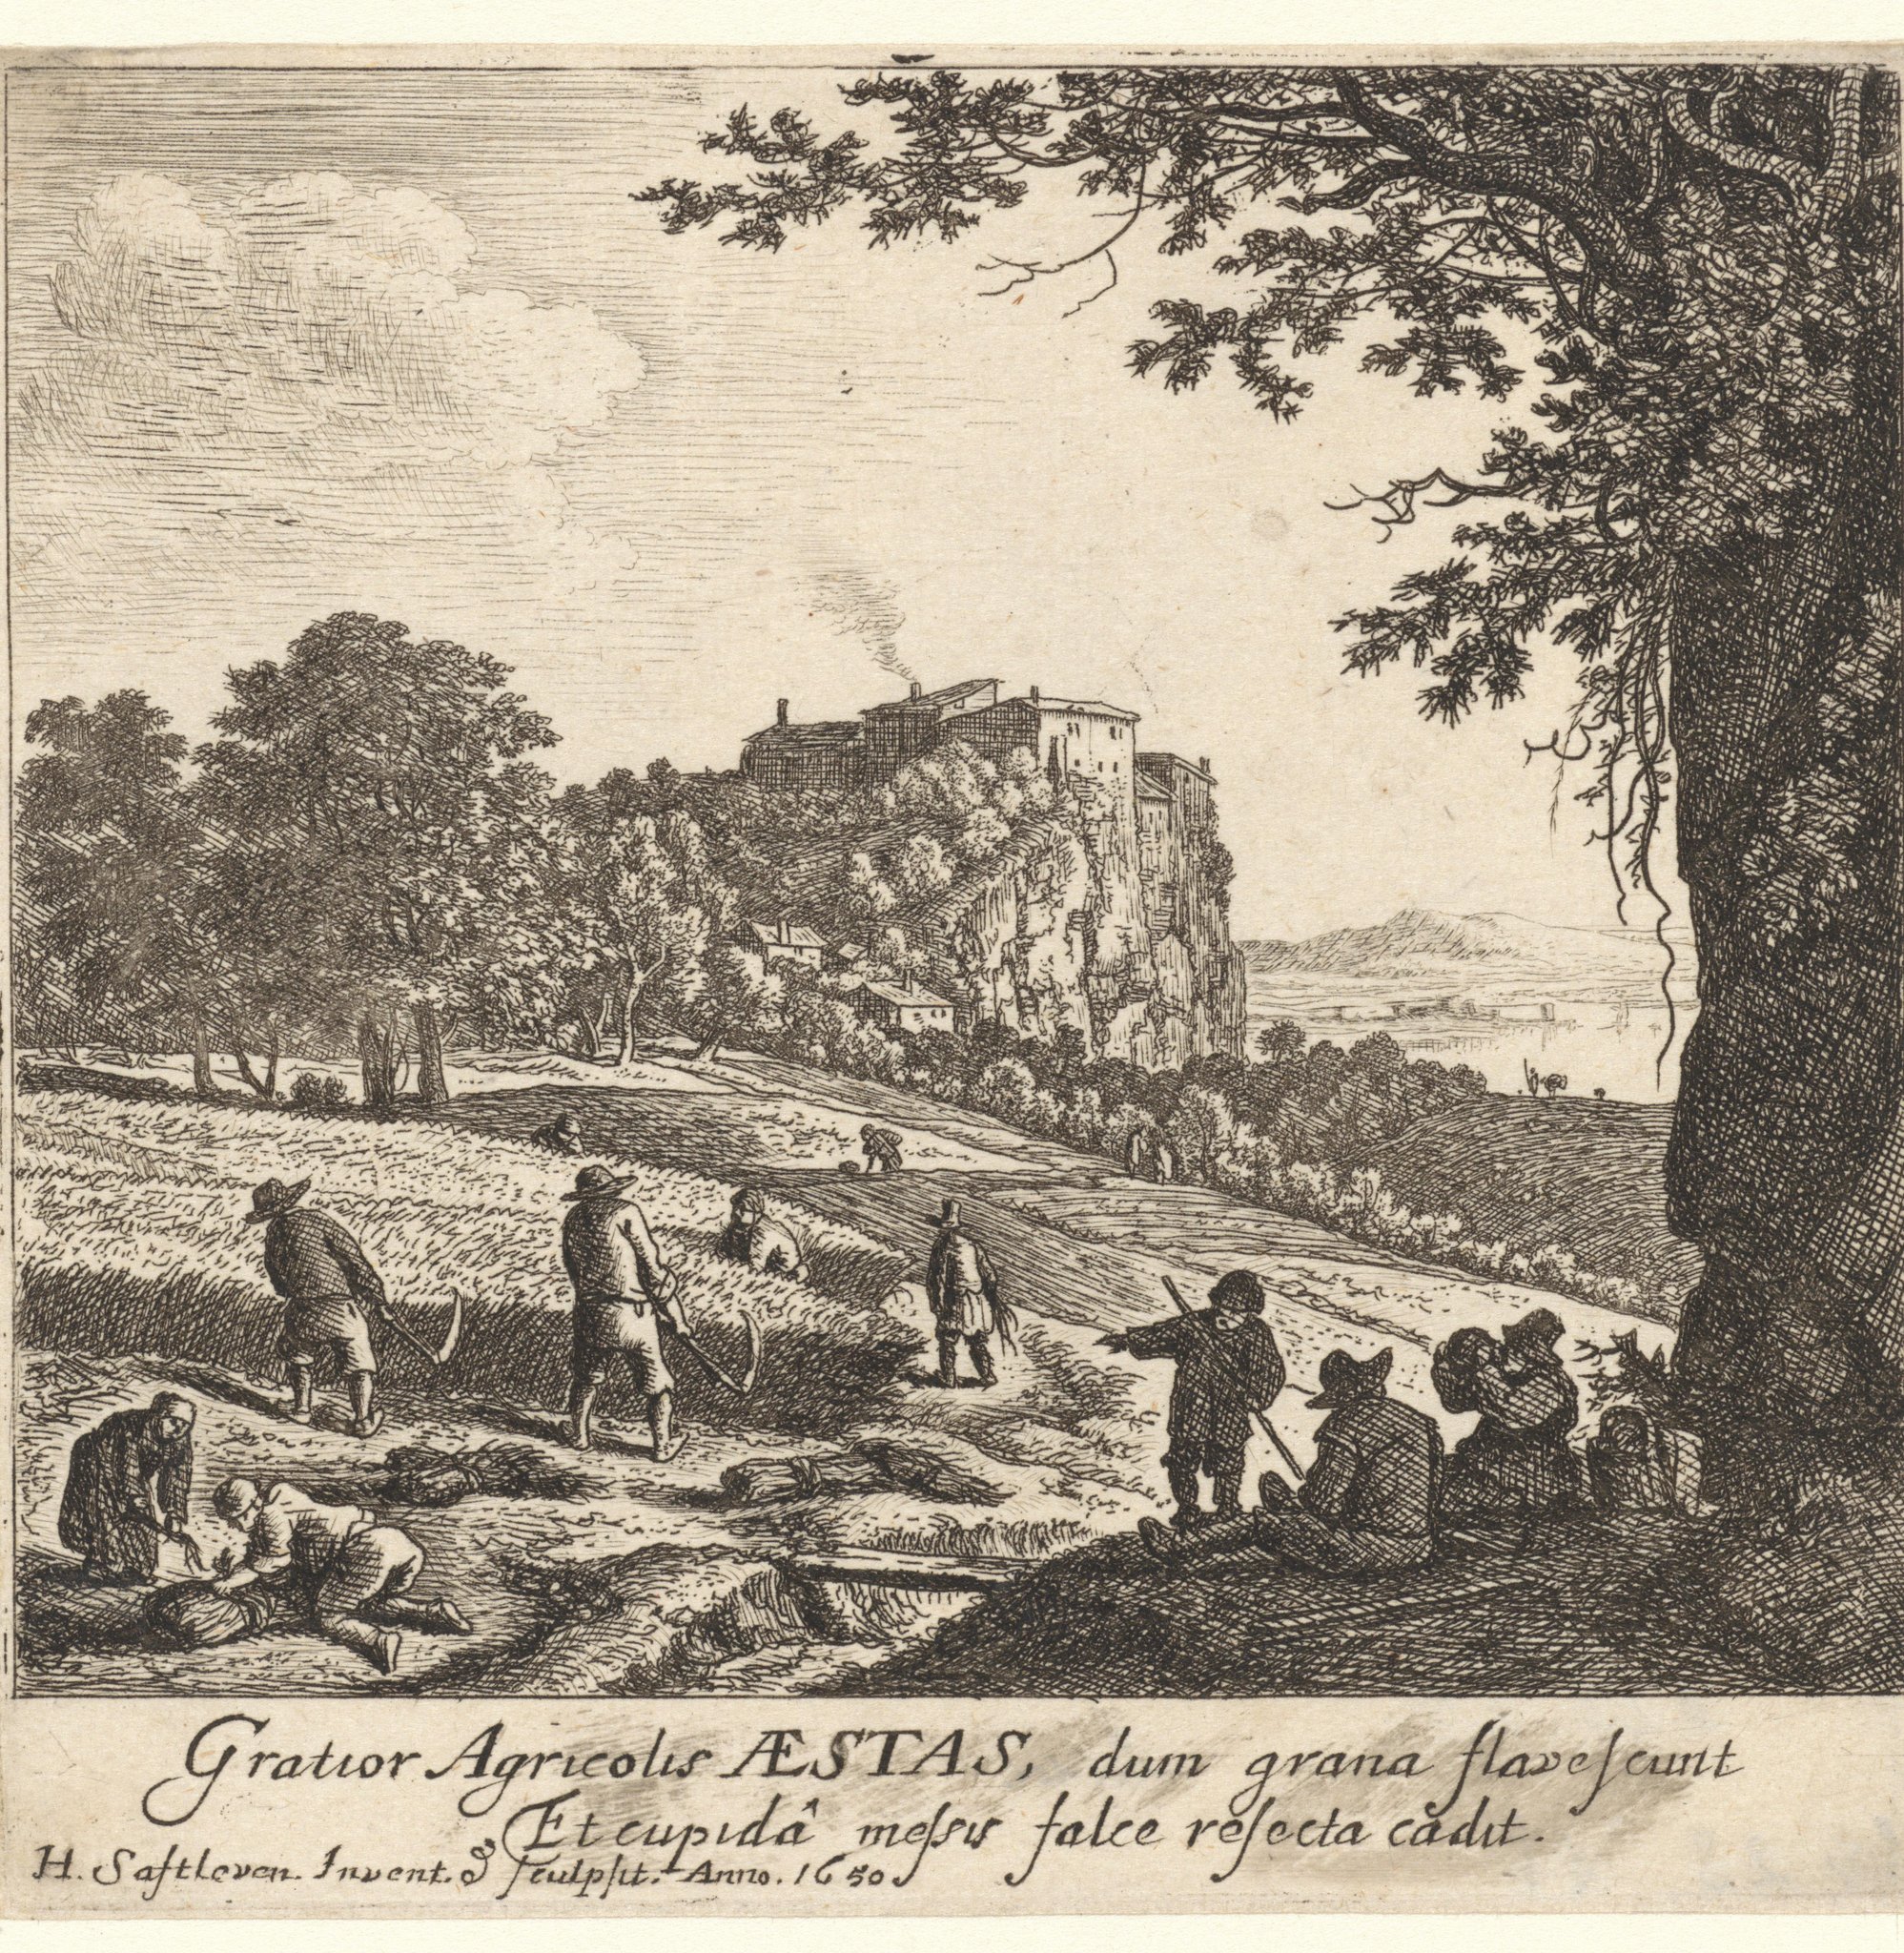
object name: print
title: De vier seizoenen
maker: herman saftleven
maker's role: draughtsman, painter, print maker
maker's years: 1609-1685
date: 1650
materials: paper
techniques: etching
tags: harvest, river, village, summer landscape; landscape symbolizing summer (the four seasons of the year), rocks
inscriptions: date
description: Gezicht op een glooiend landschap met op de voorgrond werklieden die graan oogsten. Op de achtergrond een dorp op een rots en een breed water. Voorstelling van de zomer uit een serie van de vier seizoenen.